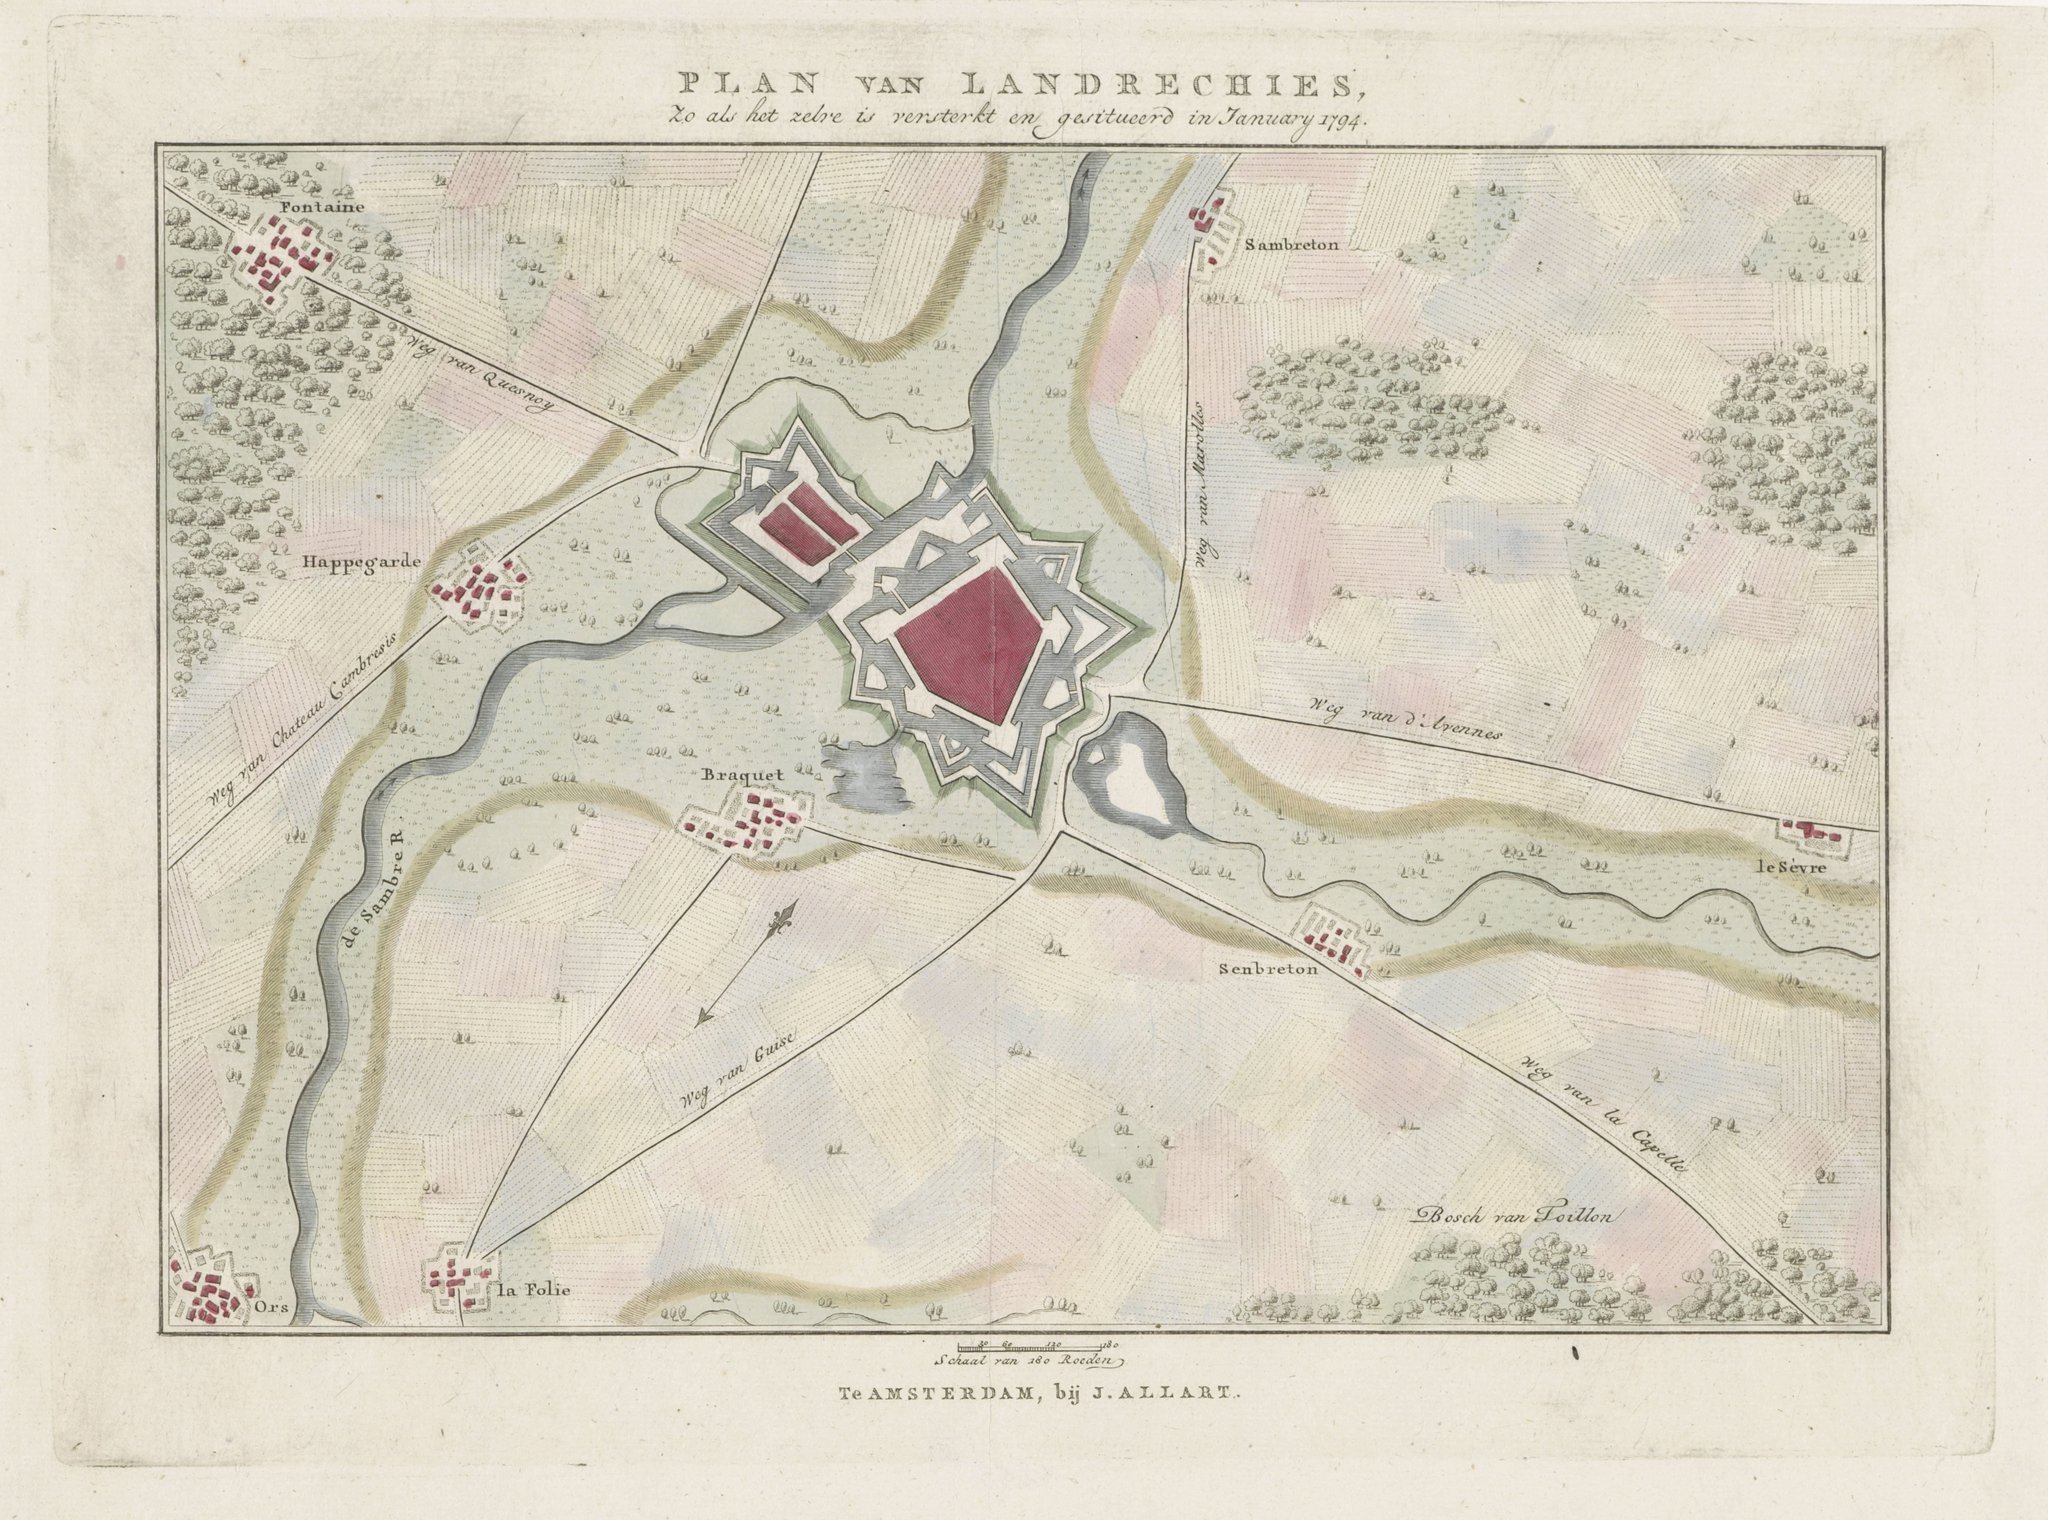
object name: map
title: Plan van de versterkingen van Landrecies, 1794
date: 1794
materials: paper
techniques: engraving, etching, hand coloring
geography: northern netherlands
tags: fortified city, maps of cities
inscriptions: collector's mark: Lugt 2228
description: Plattegrond van de versterkingen om de stad Landrecies, in januari 1794. Onderdeel van een serie van zeven bladen met plattegronden van versterkte steden in de Oostenrijkse Nederlanden ten tijde van de tweede Franse inval onder generaal Pichu in 1794.